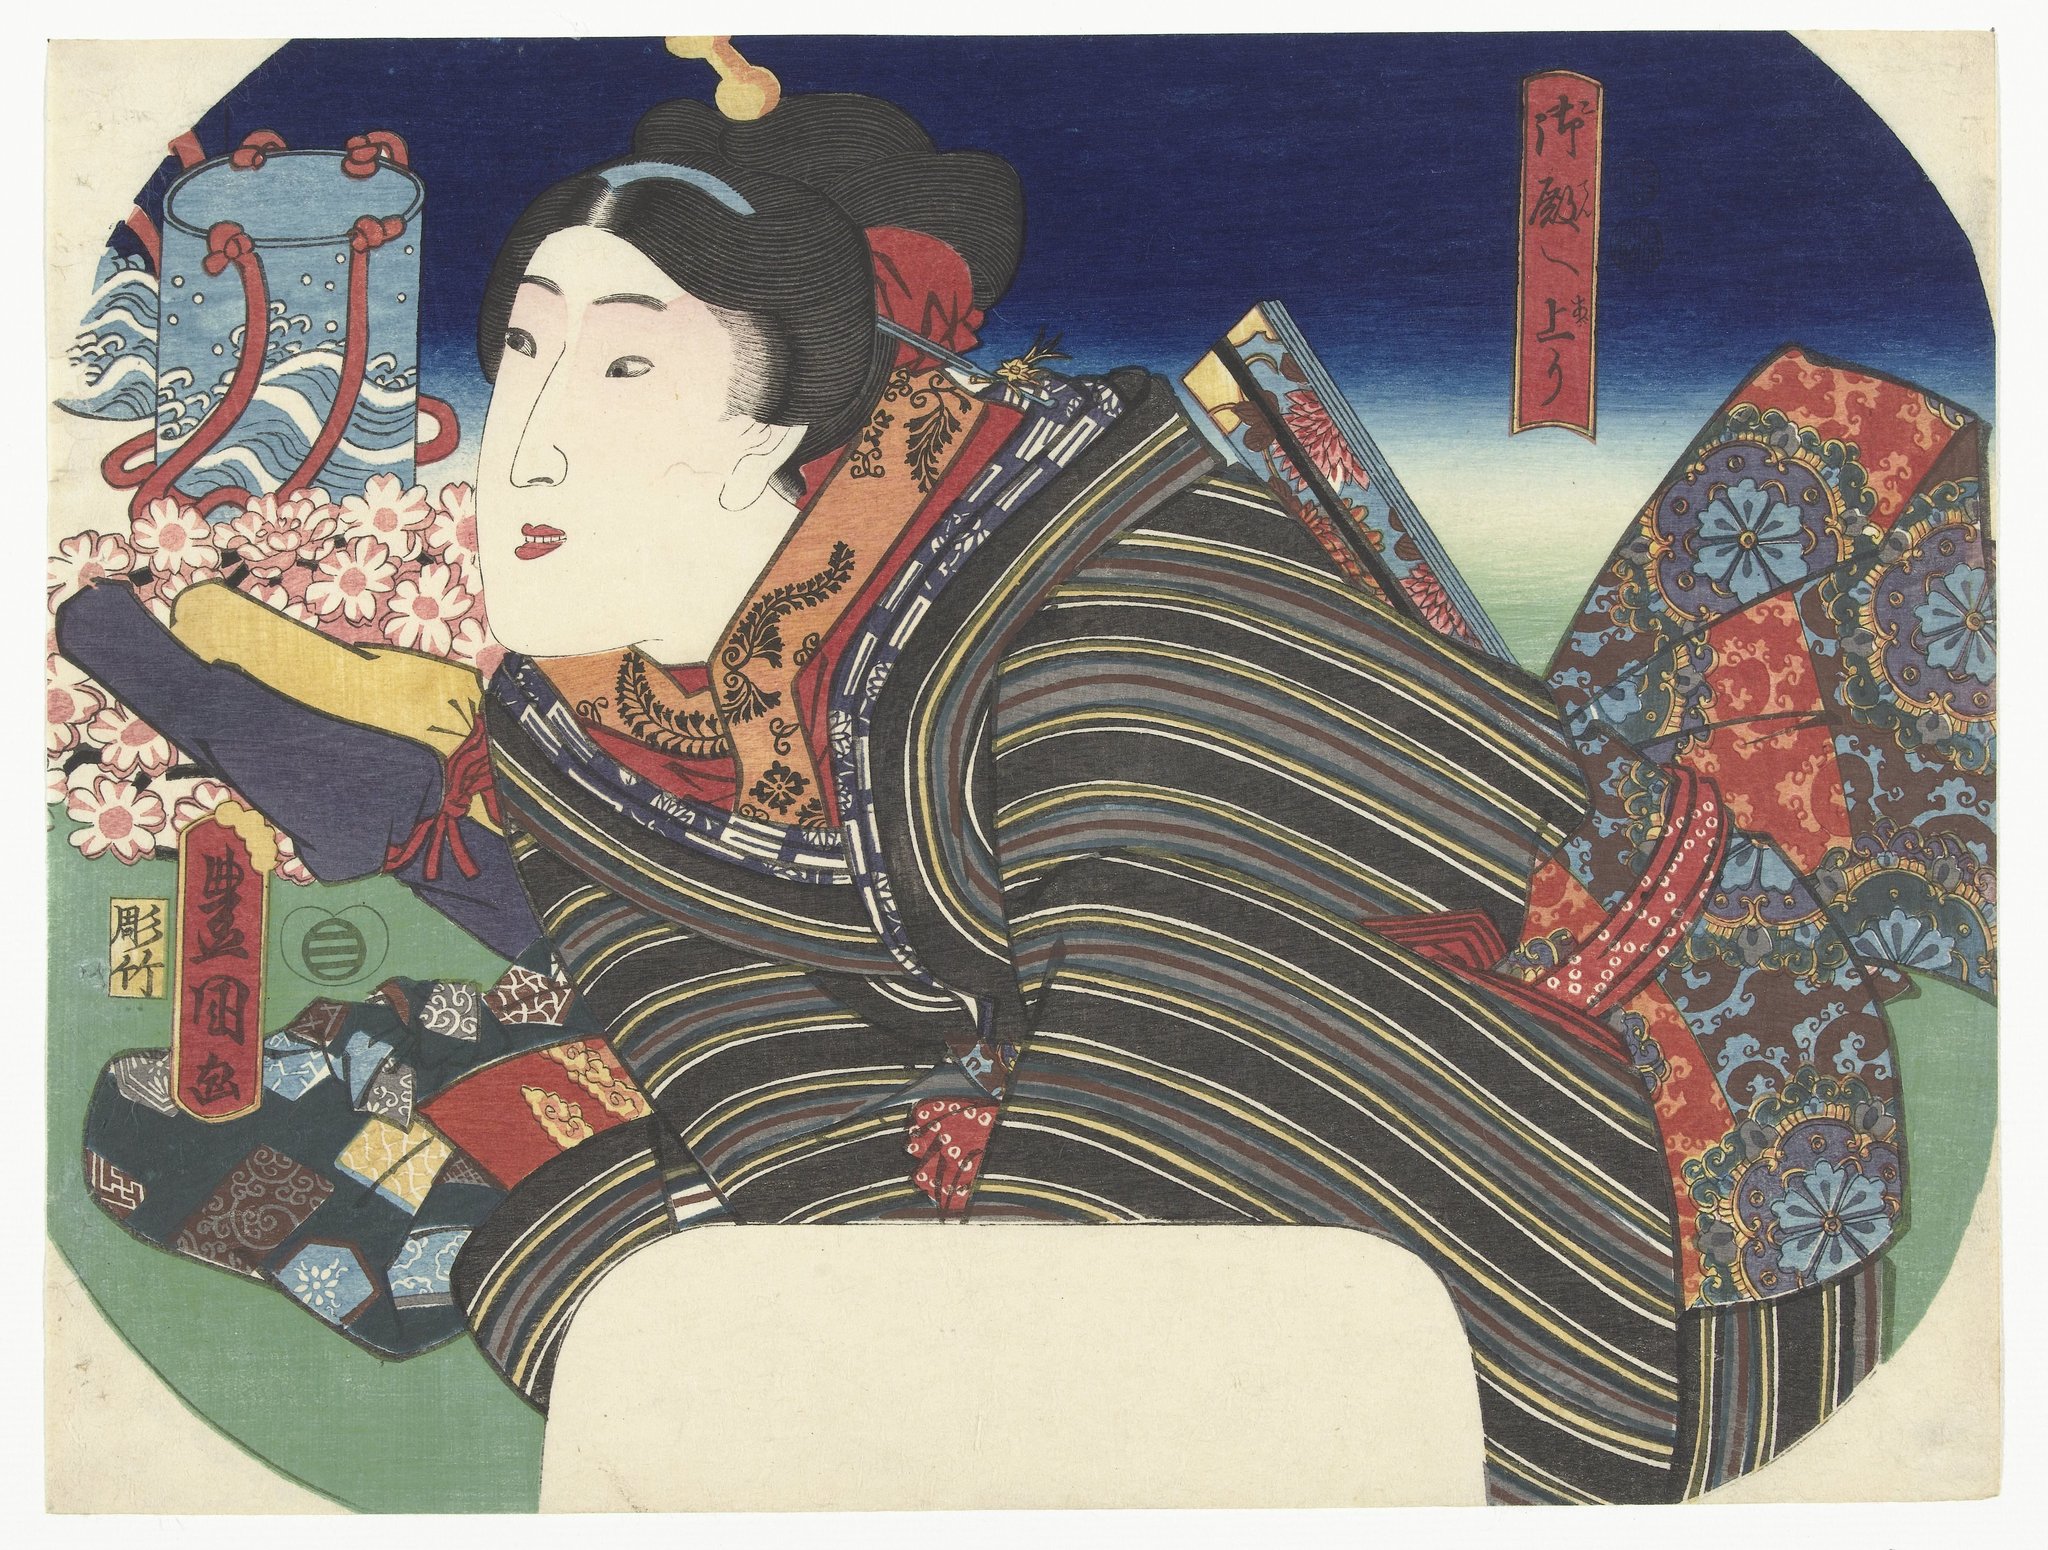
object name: print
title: Vrouw met waterpotten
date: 1850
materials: paper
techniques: woodcut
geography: japan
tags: fan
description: Waaierprent; vrouw in gestreepte kimono, van opzij gezien, met op haar rug een dichte waaier waarop patroon van chrysanten, kijkend in de richting van twee potten met golvenpatroon, waaronder roze bloemen.